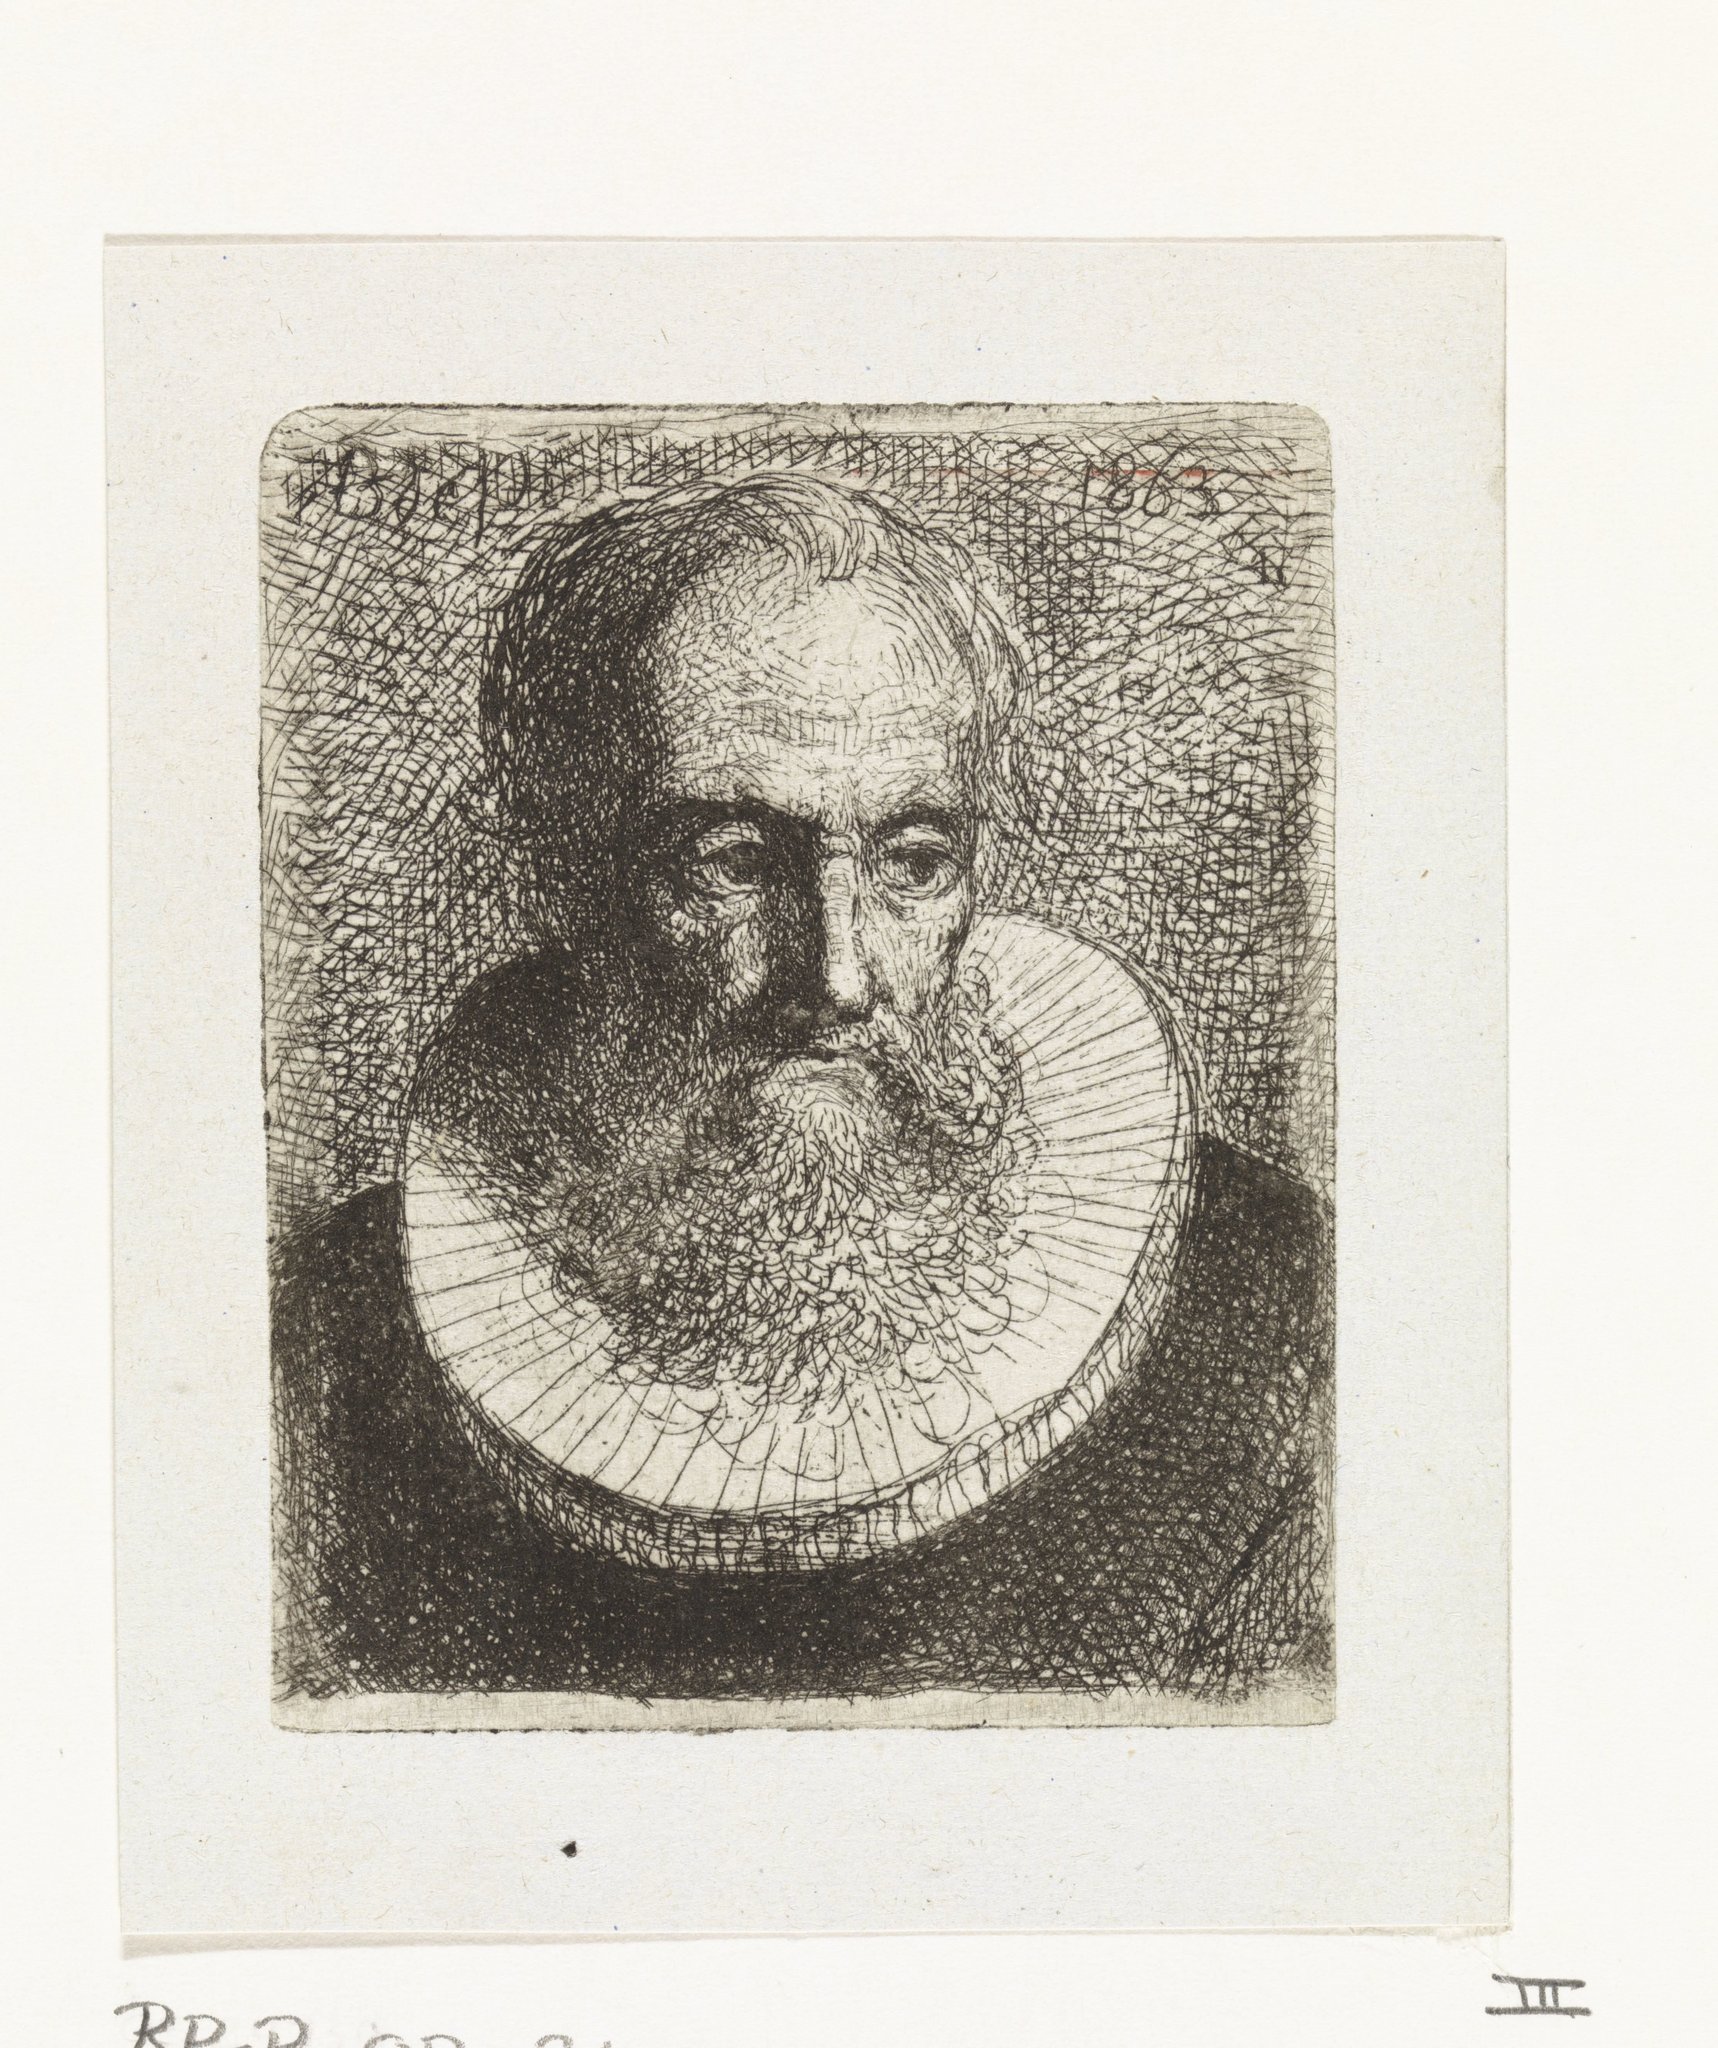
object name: print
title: Portret van een onbekende man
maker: bastiaan de poorter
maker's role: painter, print maker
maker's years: 1813-1880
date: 1863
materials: paper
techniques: etching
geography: the hague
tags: anonymous historical person portrayed alone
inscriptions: collector's mark: Lugt 2228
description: Portret van een man met baard en plooikraag.